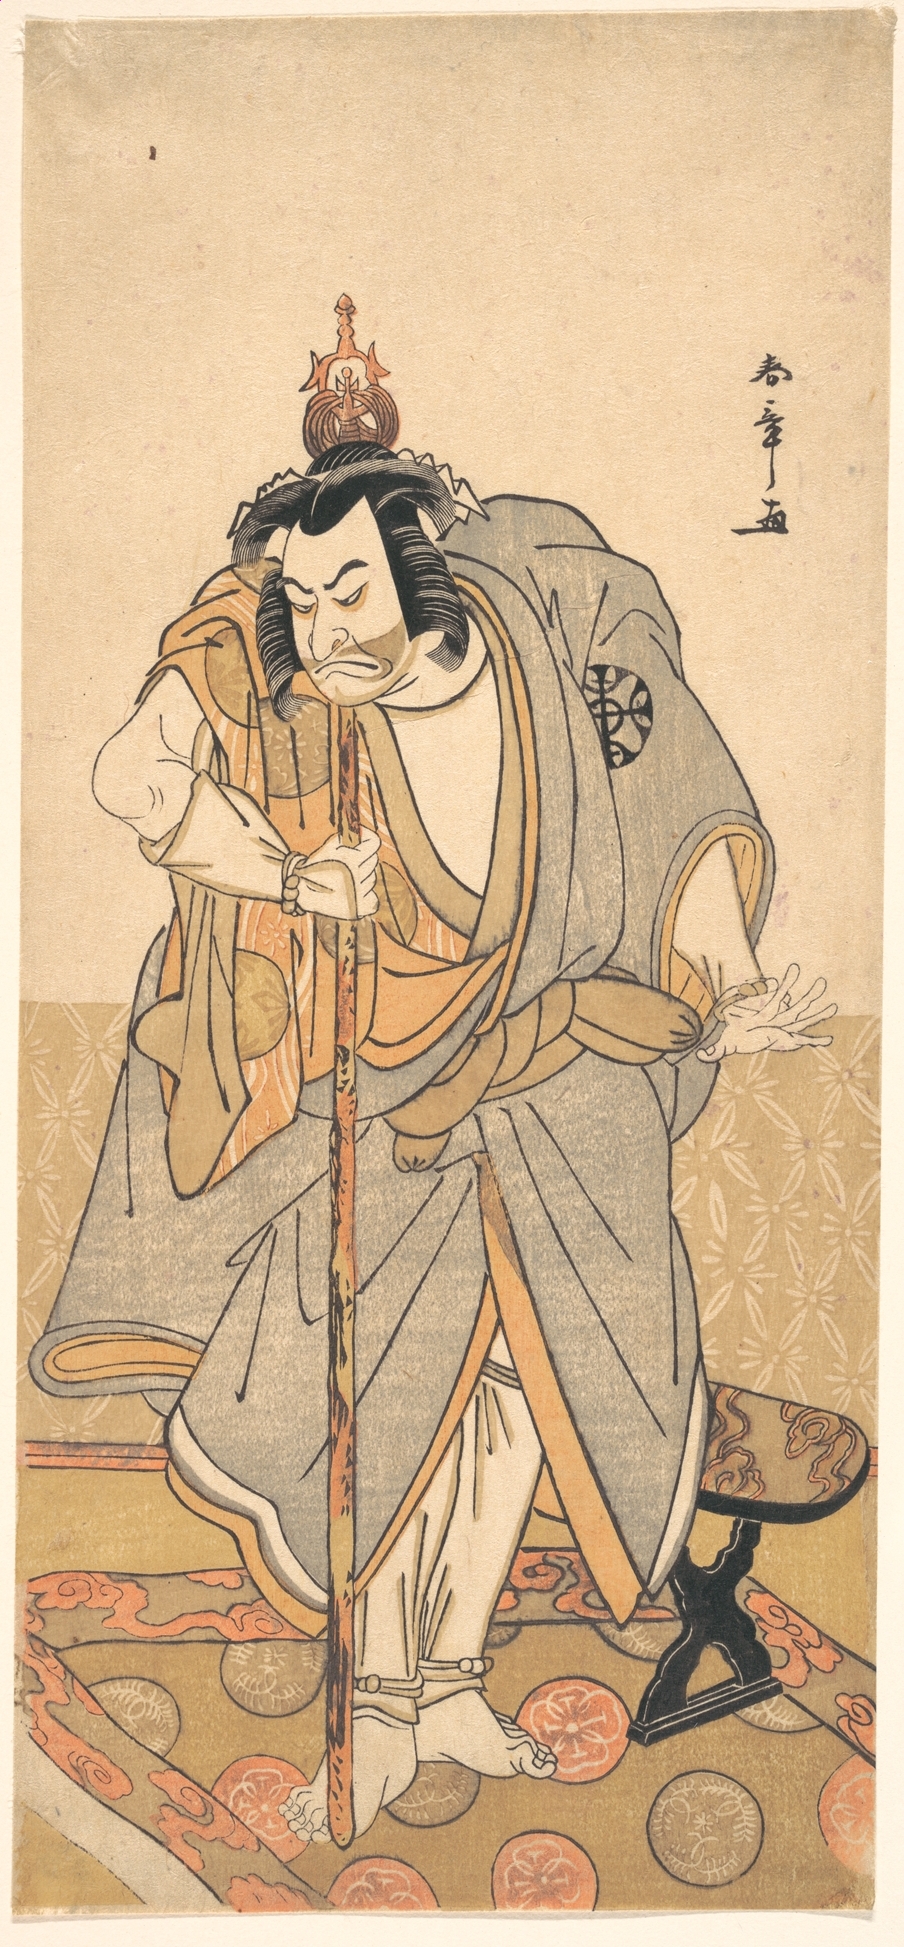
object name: woodblock print nishiki e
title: The actor Nakamura Nakazo as a rokuju-rokubu (pilgrim to Buddhist temple)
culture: japanese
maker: katsukawa shunshō 勝川春章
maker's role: artist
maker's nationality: japanese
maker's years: 1726-1792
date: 1780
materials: ink, paper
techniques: nishiki e, woodblock print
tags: men,actors